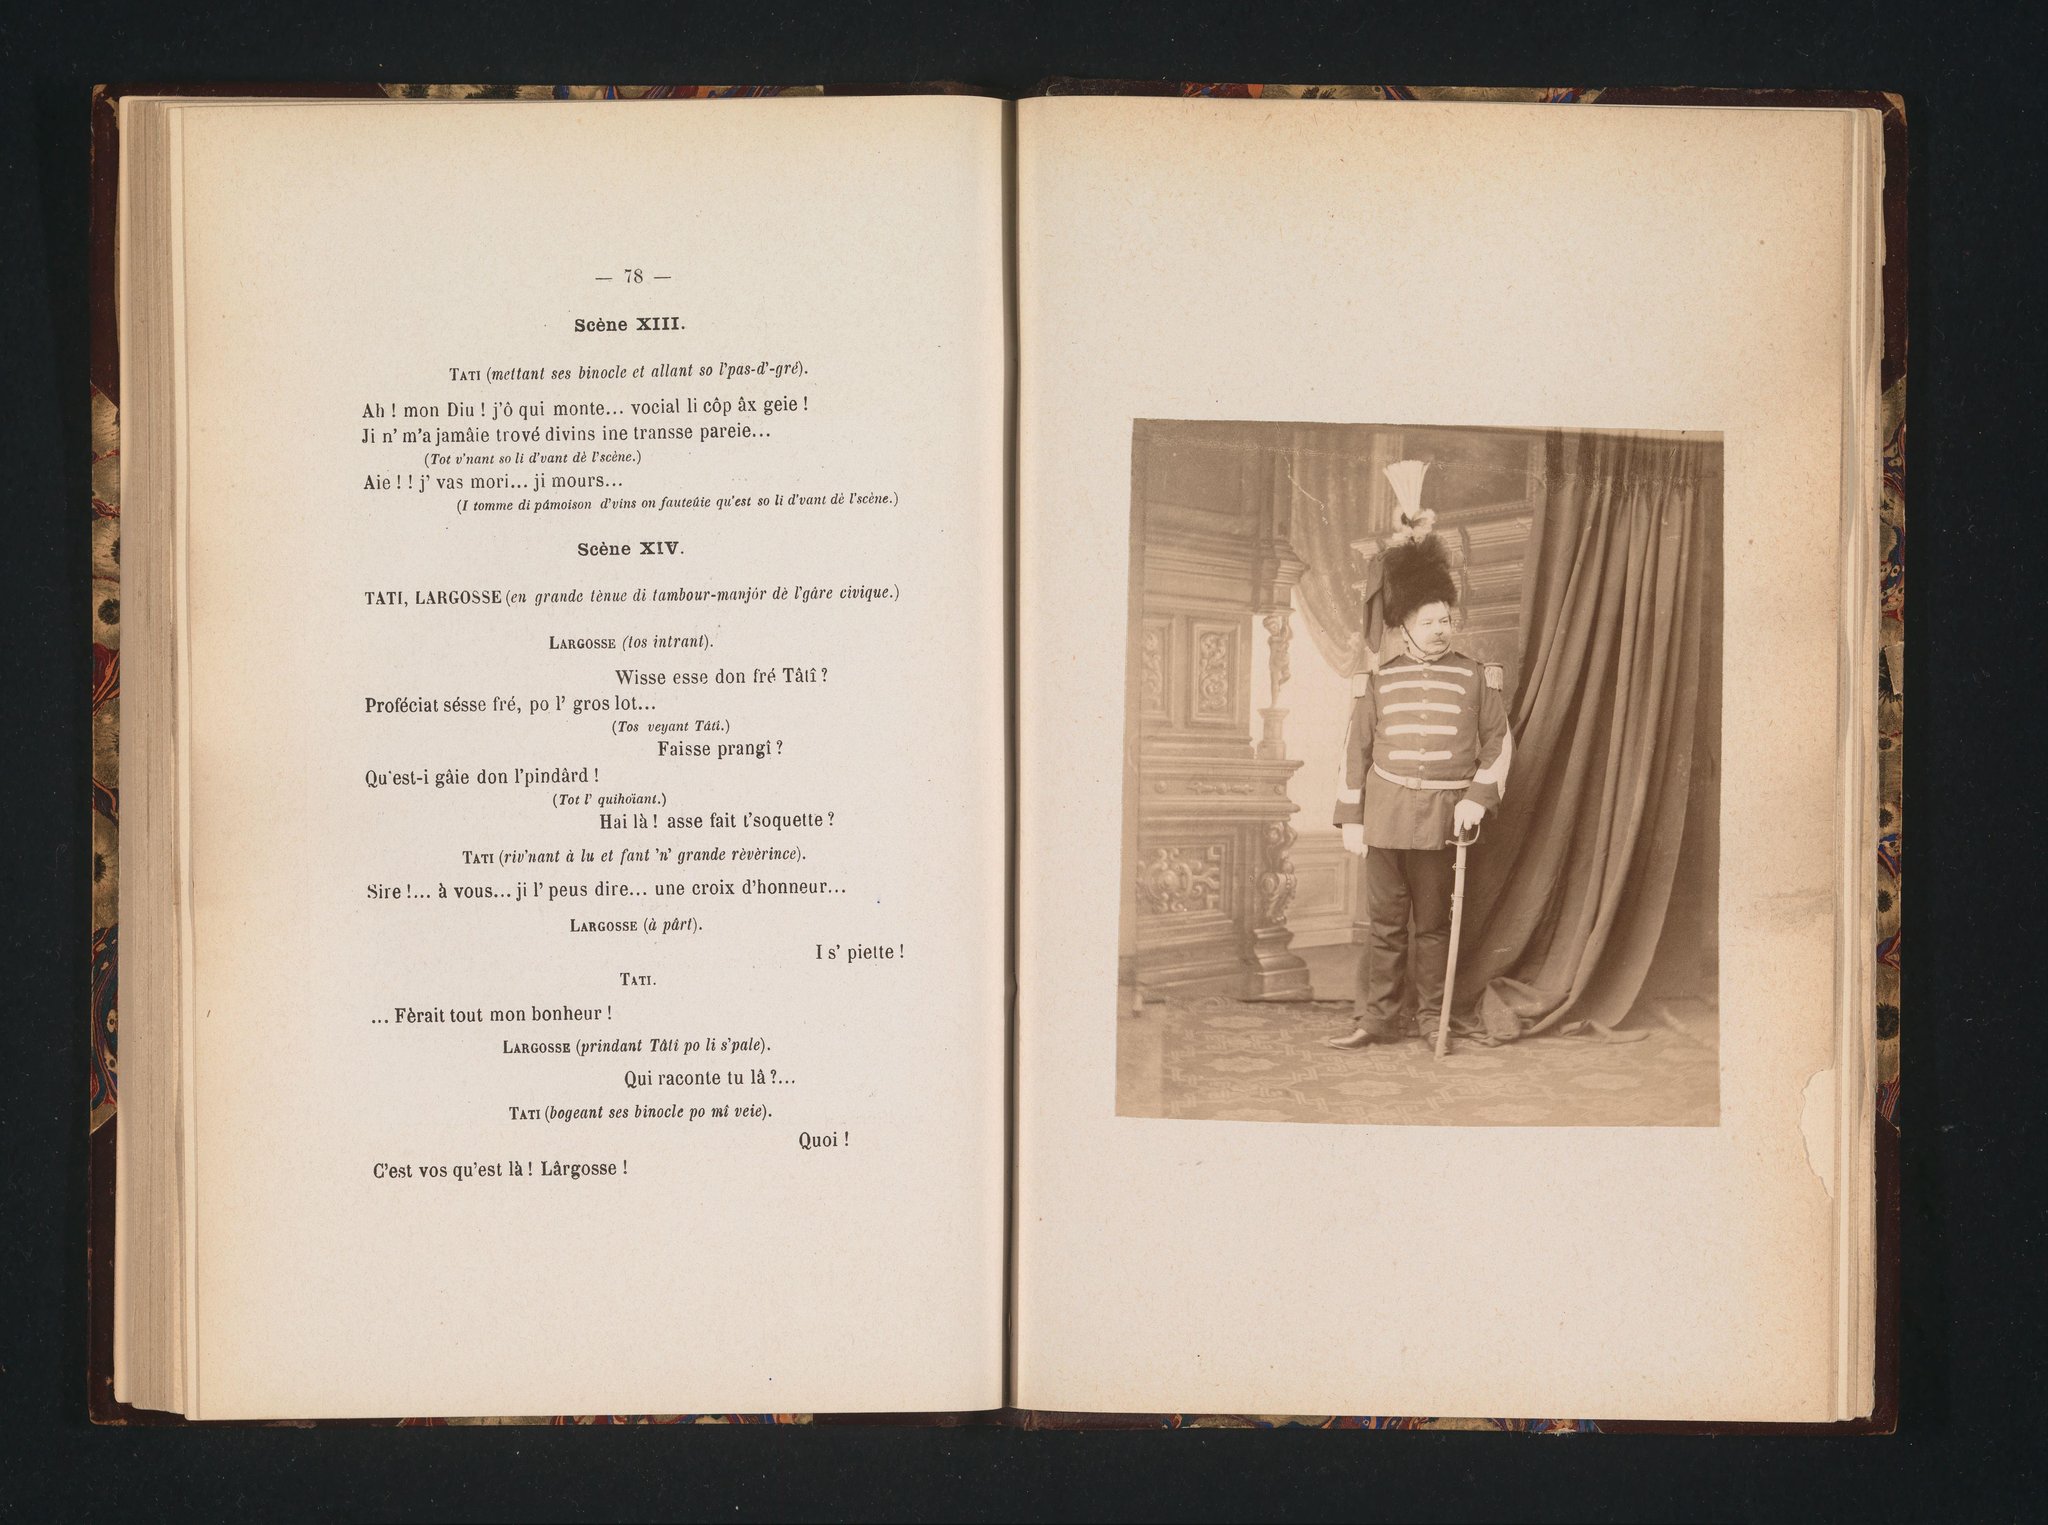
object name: page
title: Scène uit het theaterstuk Tati l'perriqui met een man in kostuum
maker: Anonymous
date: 1888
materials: photographic support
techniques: albumen print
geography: liège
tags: stage costume, theatre, theatrical performance, actor (on the stage)